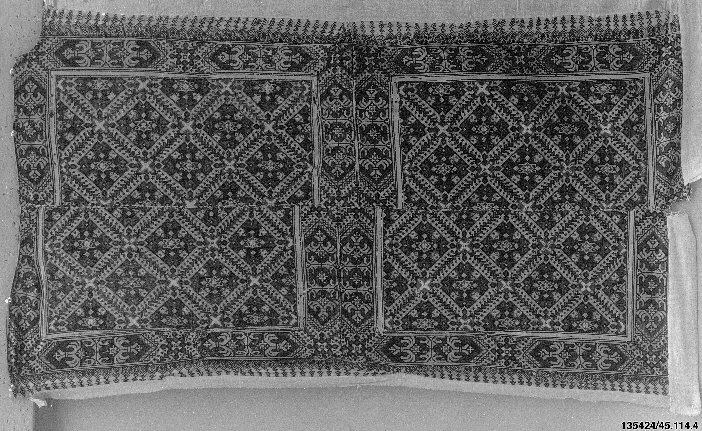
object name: panel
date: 1701-1800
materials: linen, silk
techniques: embroidery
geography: morocco